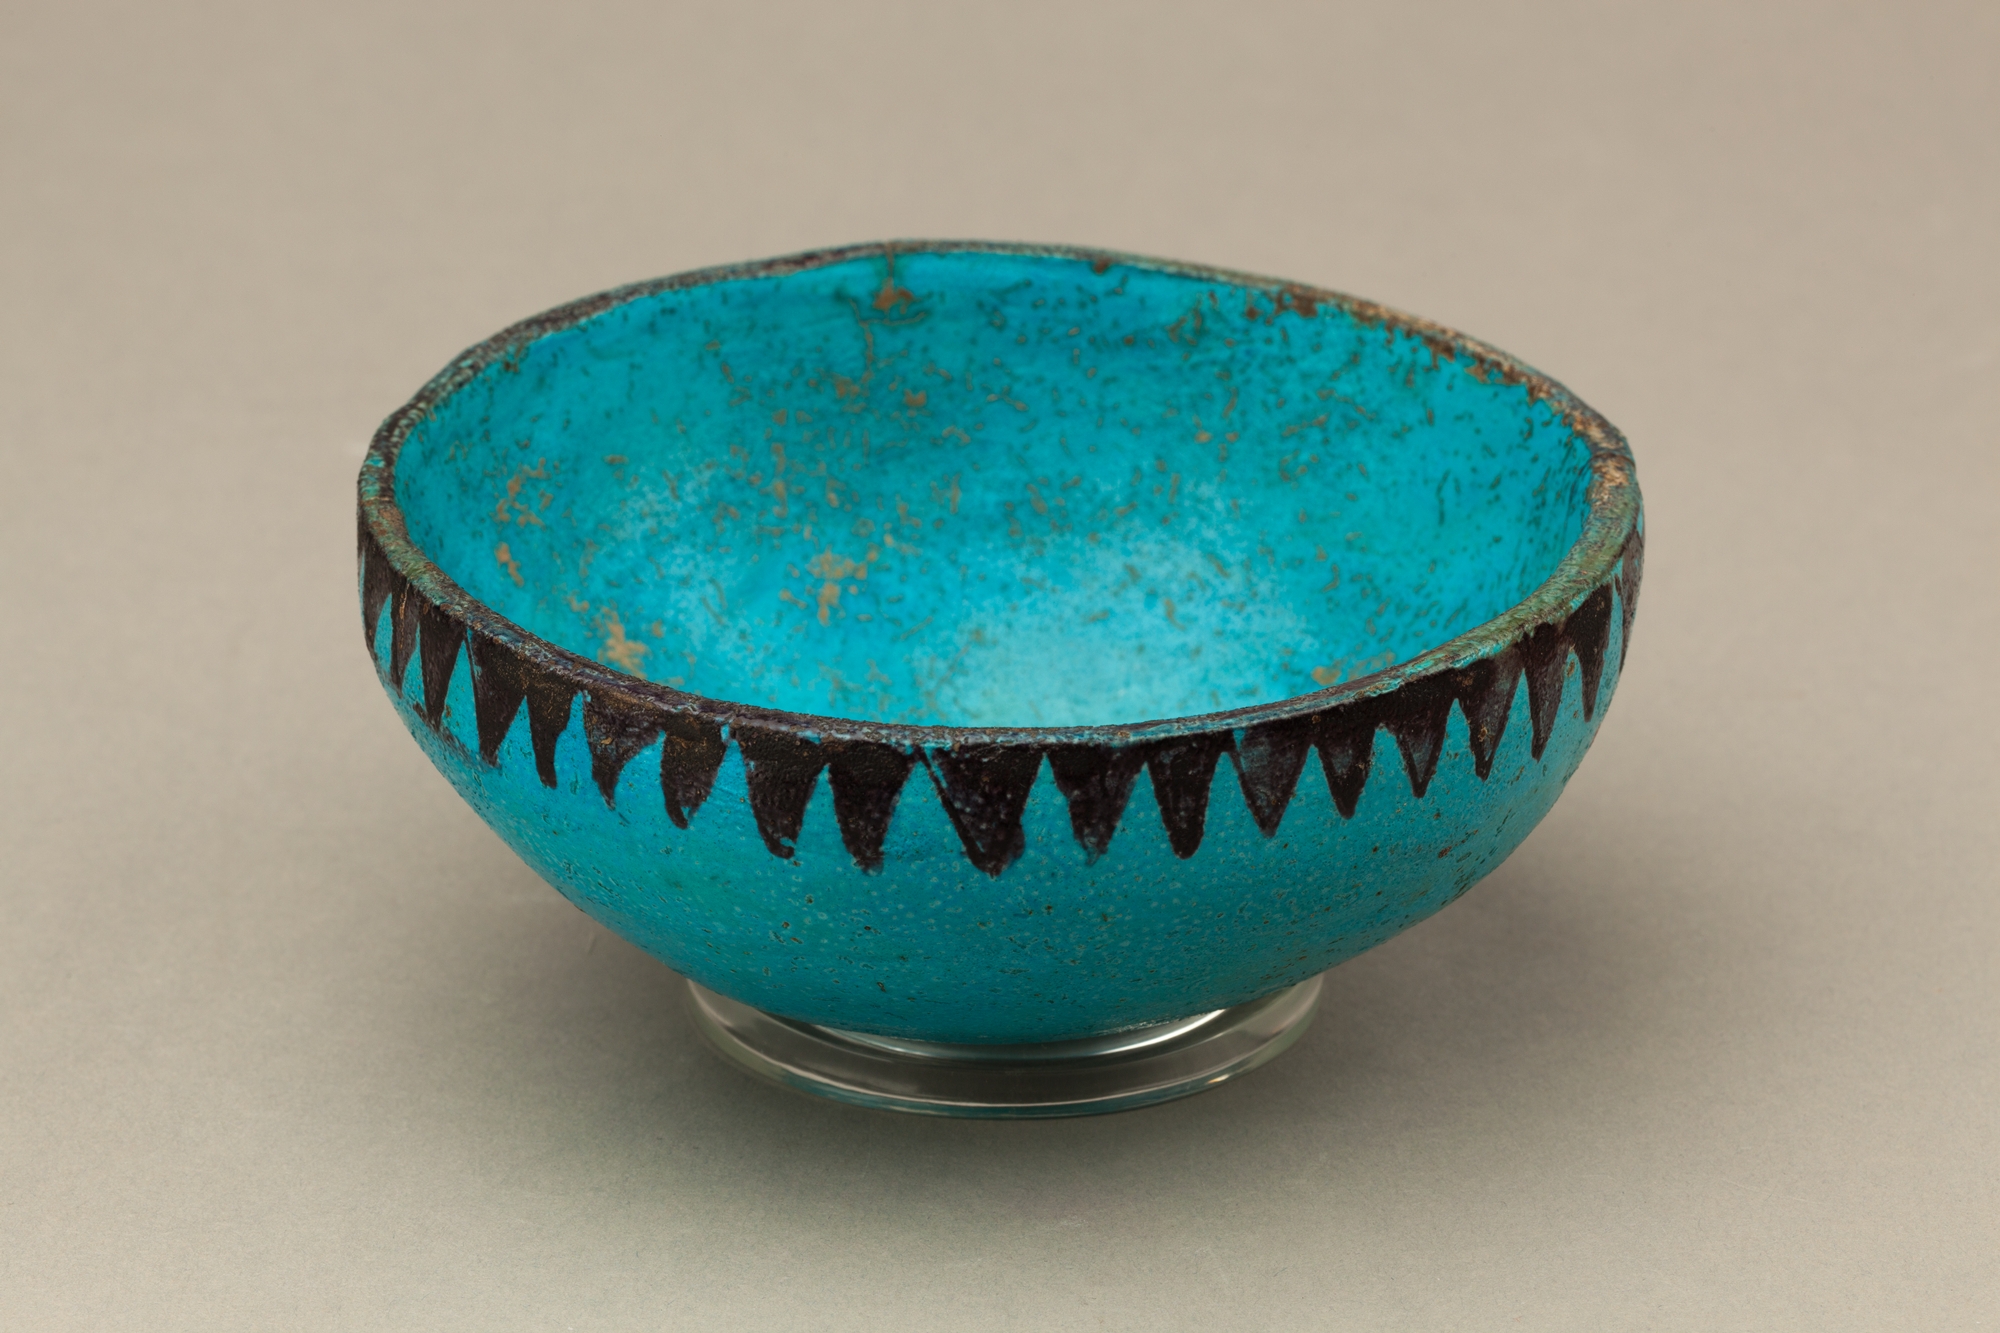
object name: bowl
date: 1635-1458 BCE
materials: faience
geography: egypt